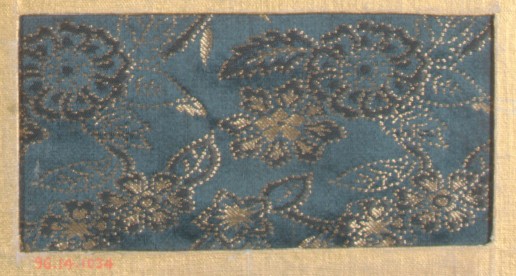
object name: piece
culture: japanese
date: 1701-1900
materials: silk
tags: flowers